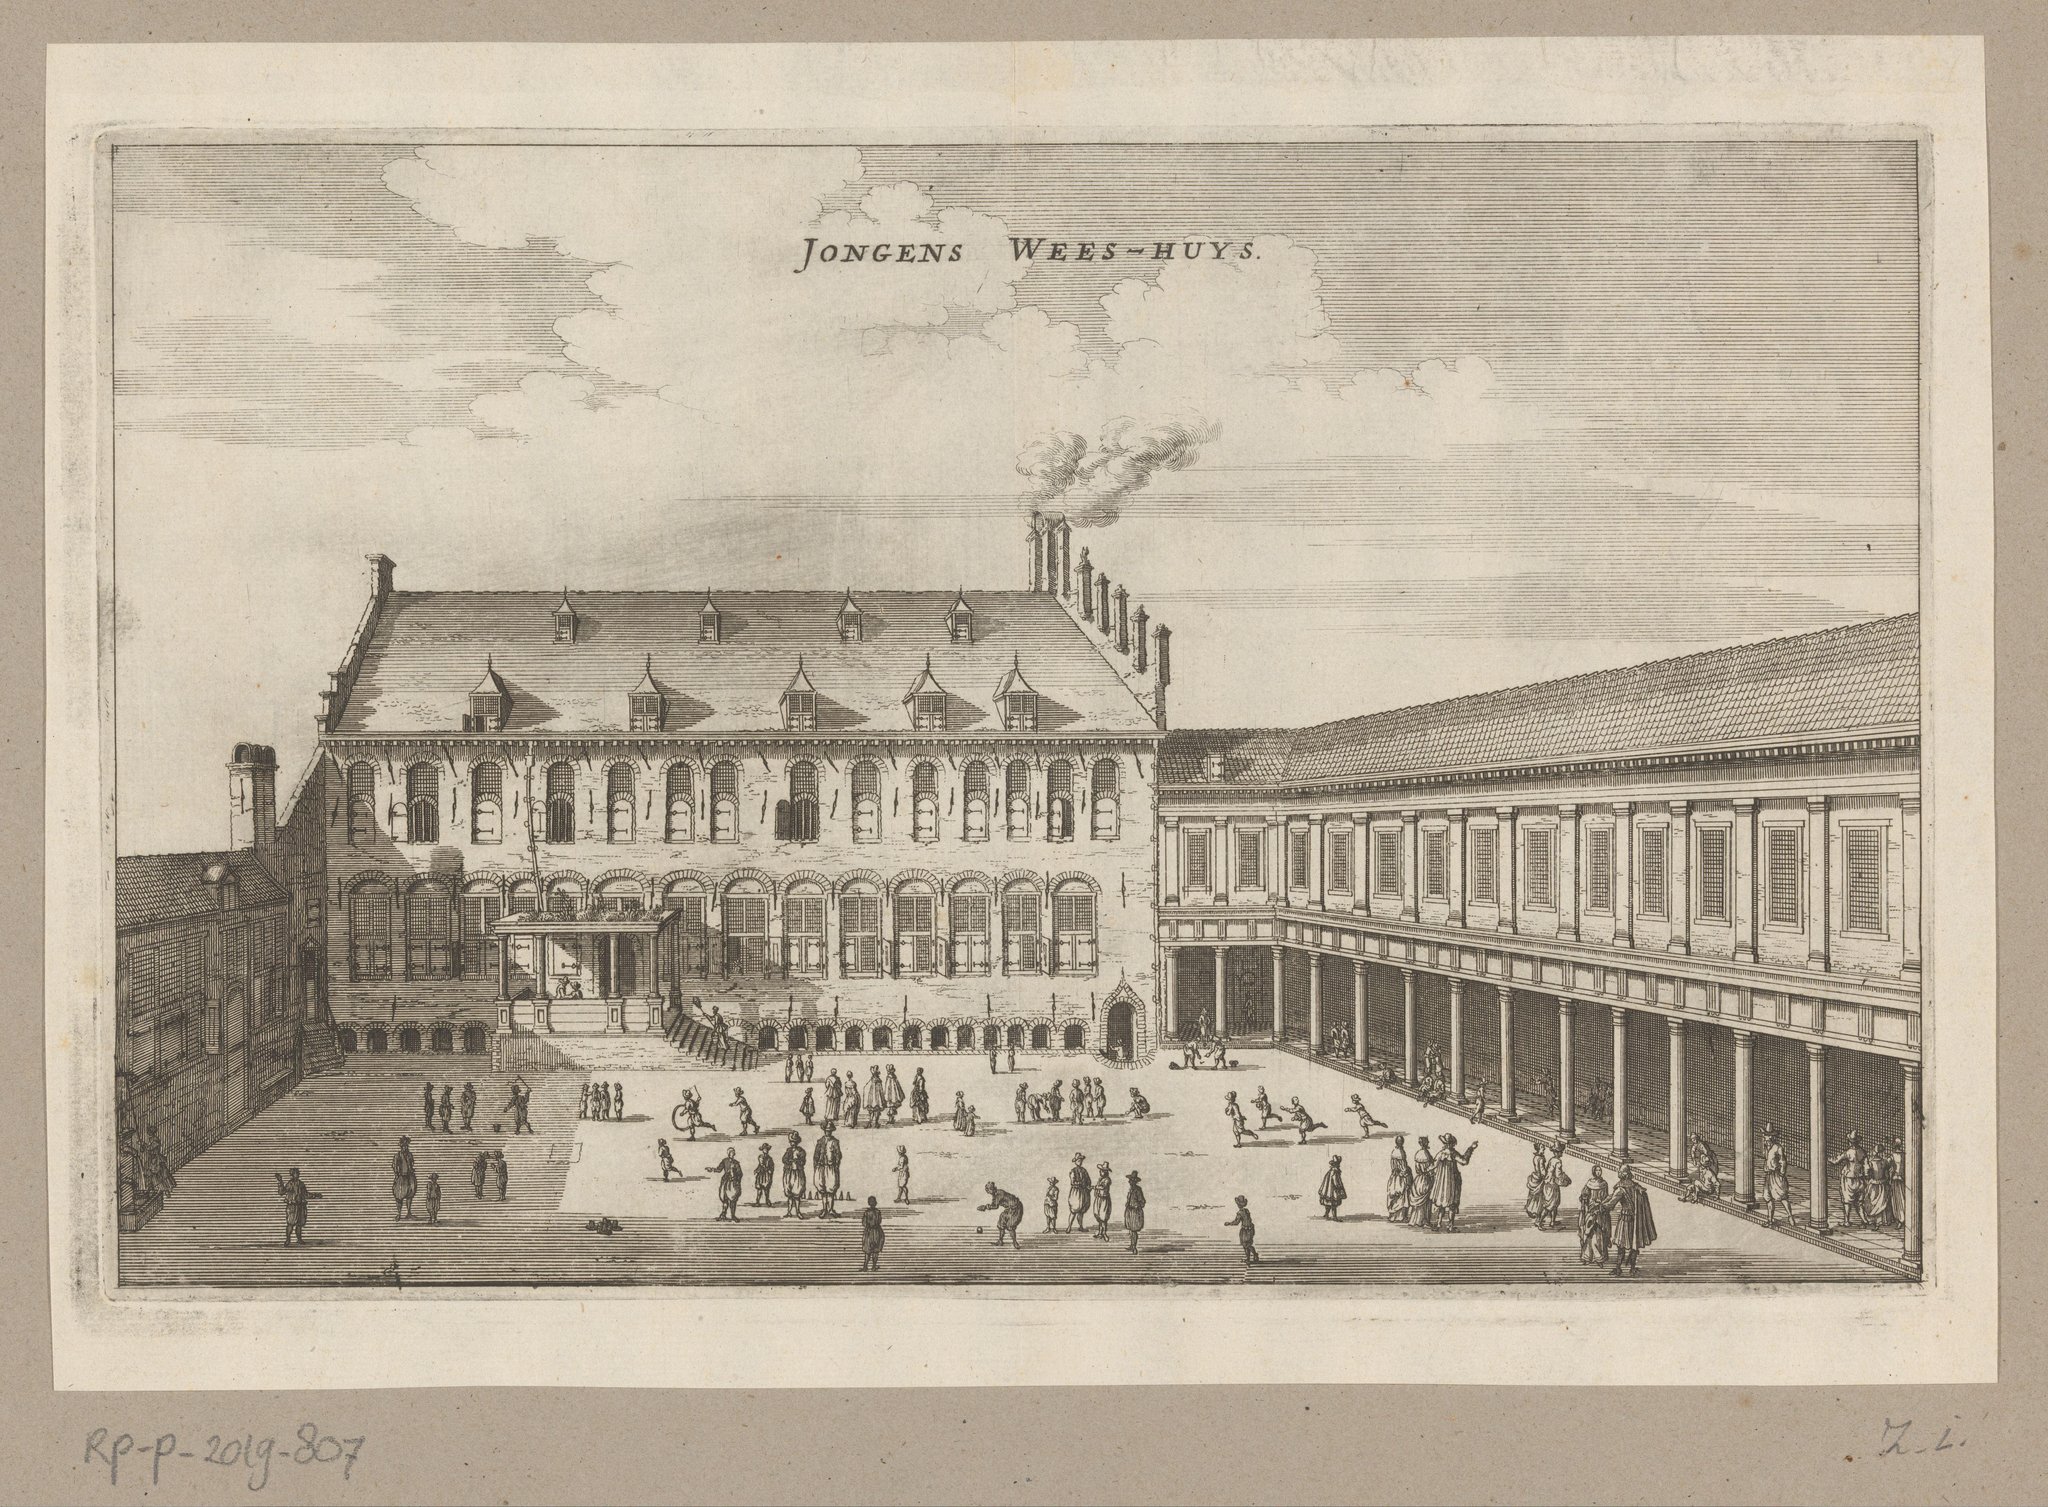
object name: print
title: Jongens wees-huys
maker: jacob van meurs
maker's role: draughtsman, print maker, publisher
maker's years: 1619-1680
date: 1663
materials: paper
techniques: engraving, etching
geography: amsterdam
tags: public welfare, courtyard, orphanage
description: Prent uit: Dapper, Olfert. Historische beschryving der stadt Amsterdam: waer in de voornaemste geschiedenissen (na een kort verhael van gansch Hollant en d'omleggende dorpen (…). Amsterdam: Jacob van Meurs, 1663. De tweede staat van de prent heeft een toegevoegde Franse titel.